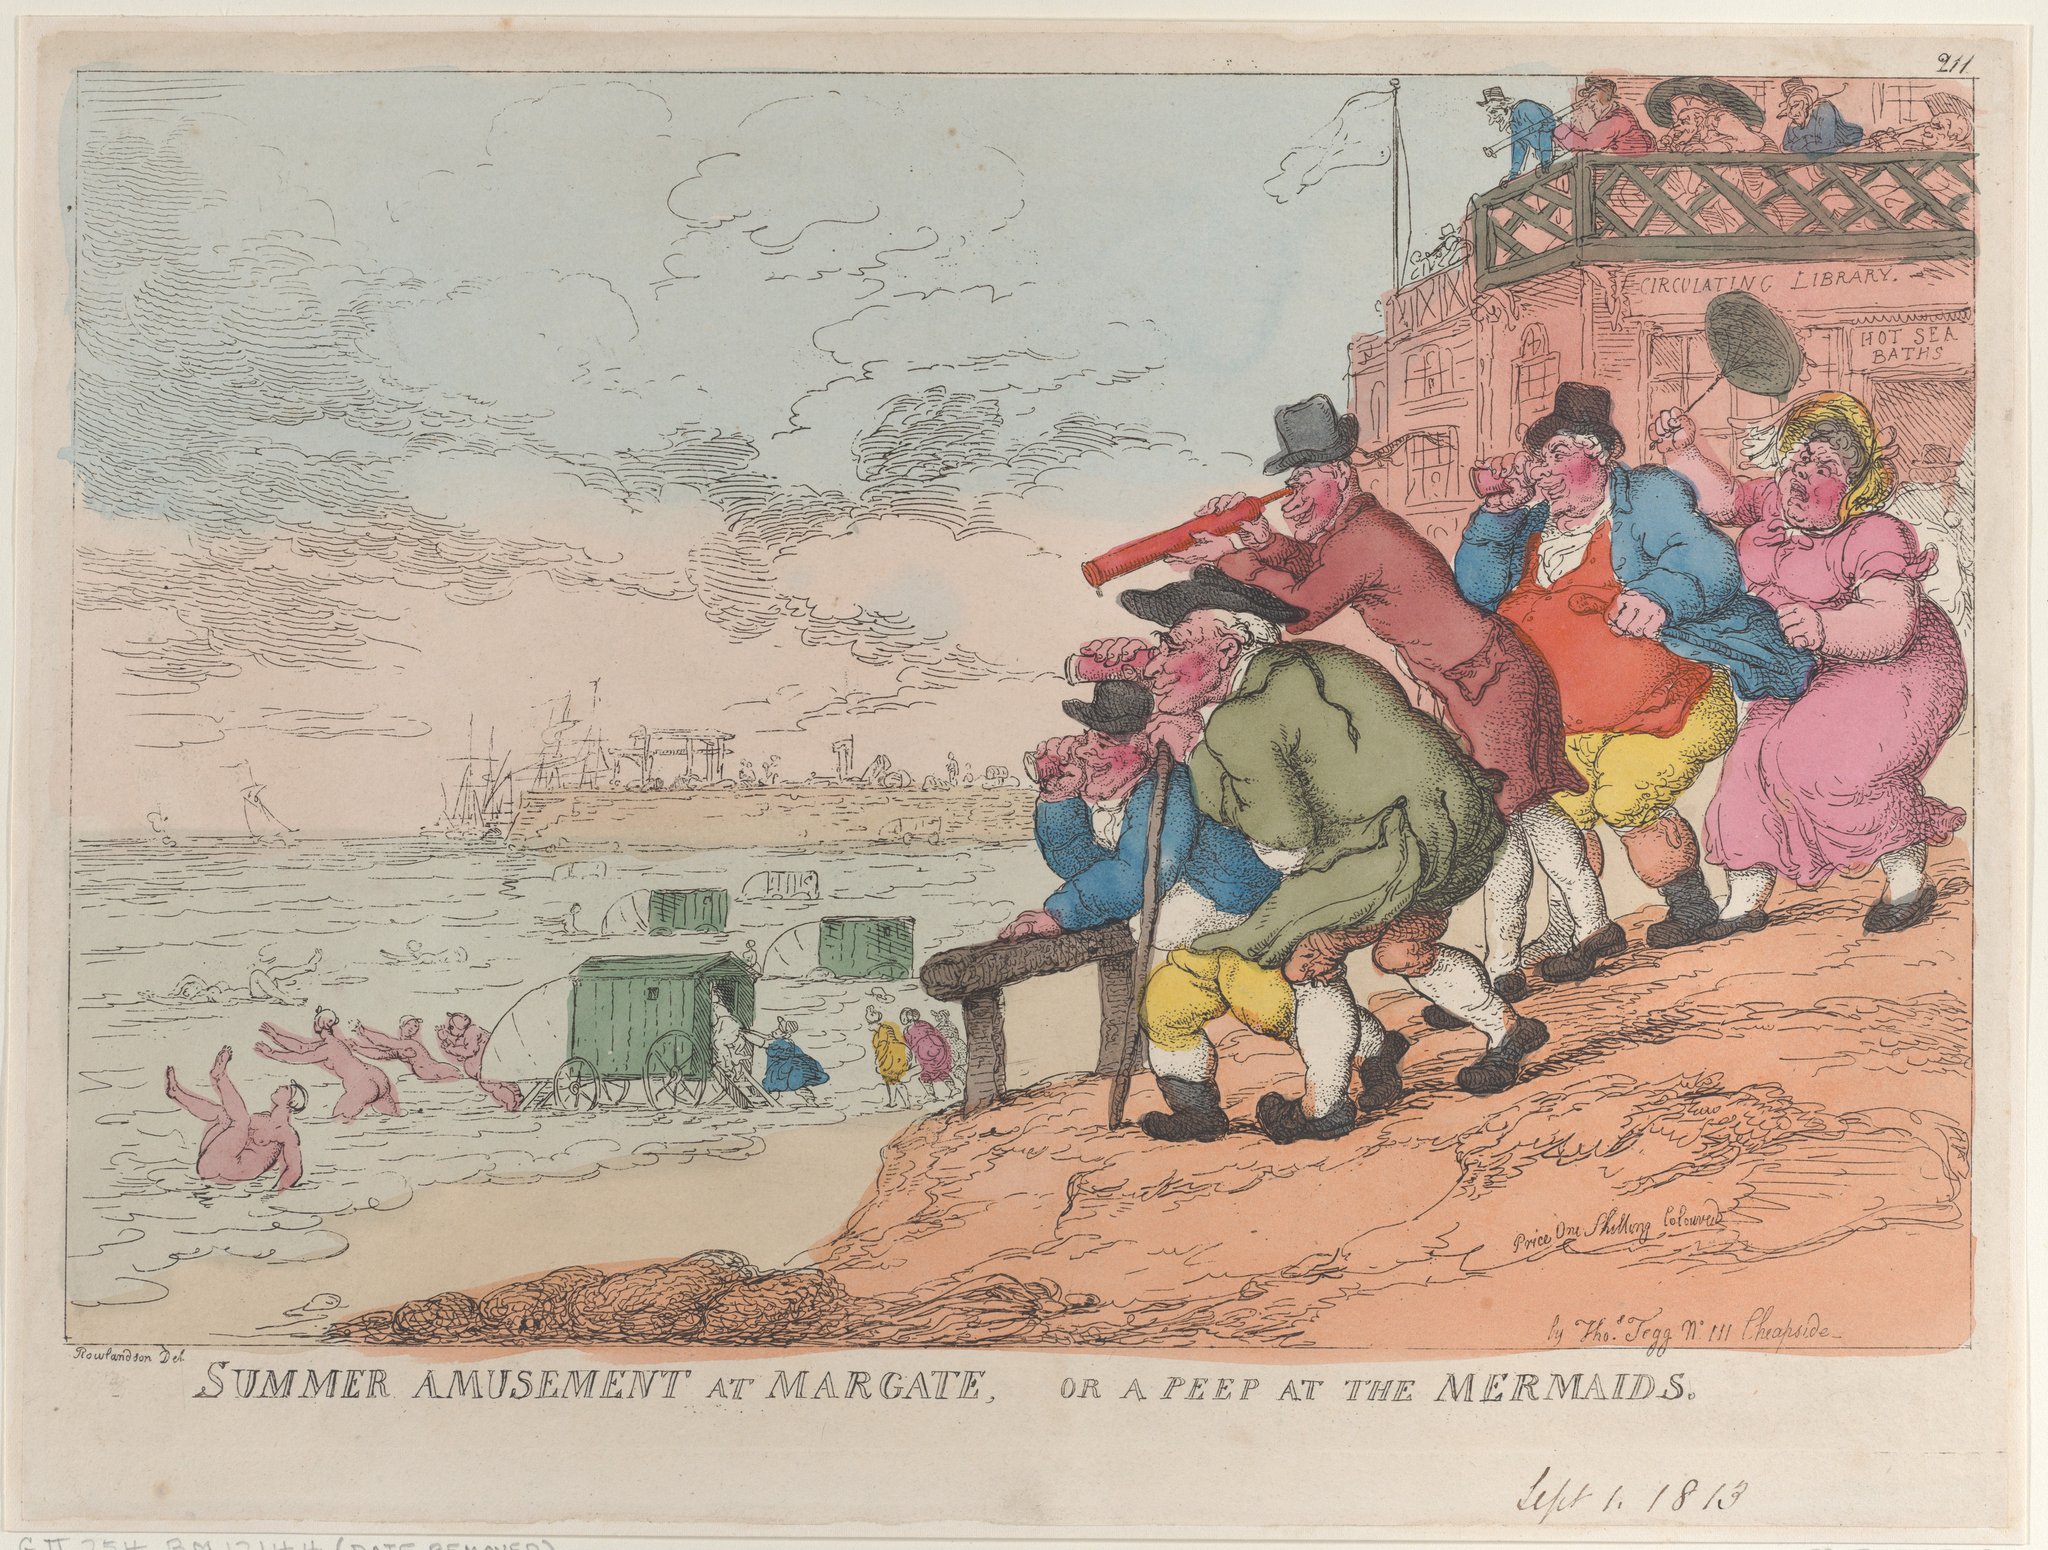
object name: print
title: Summer Amusement at Margate, or a Peep at the Mermaids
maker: thomas rowlandson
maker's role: artist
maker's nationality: british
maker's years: 1757-1827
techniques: etching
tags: satire,men,women,bathing,telescopes